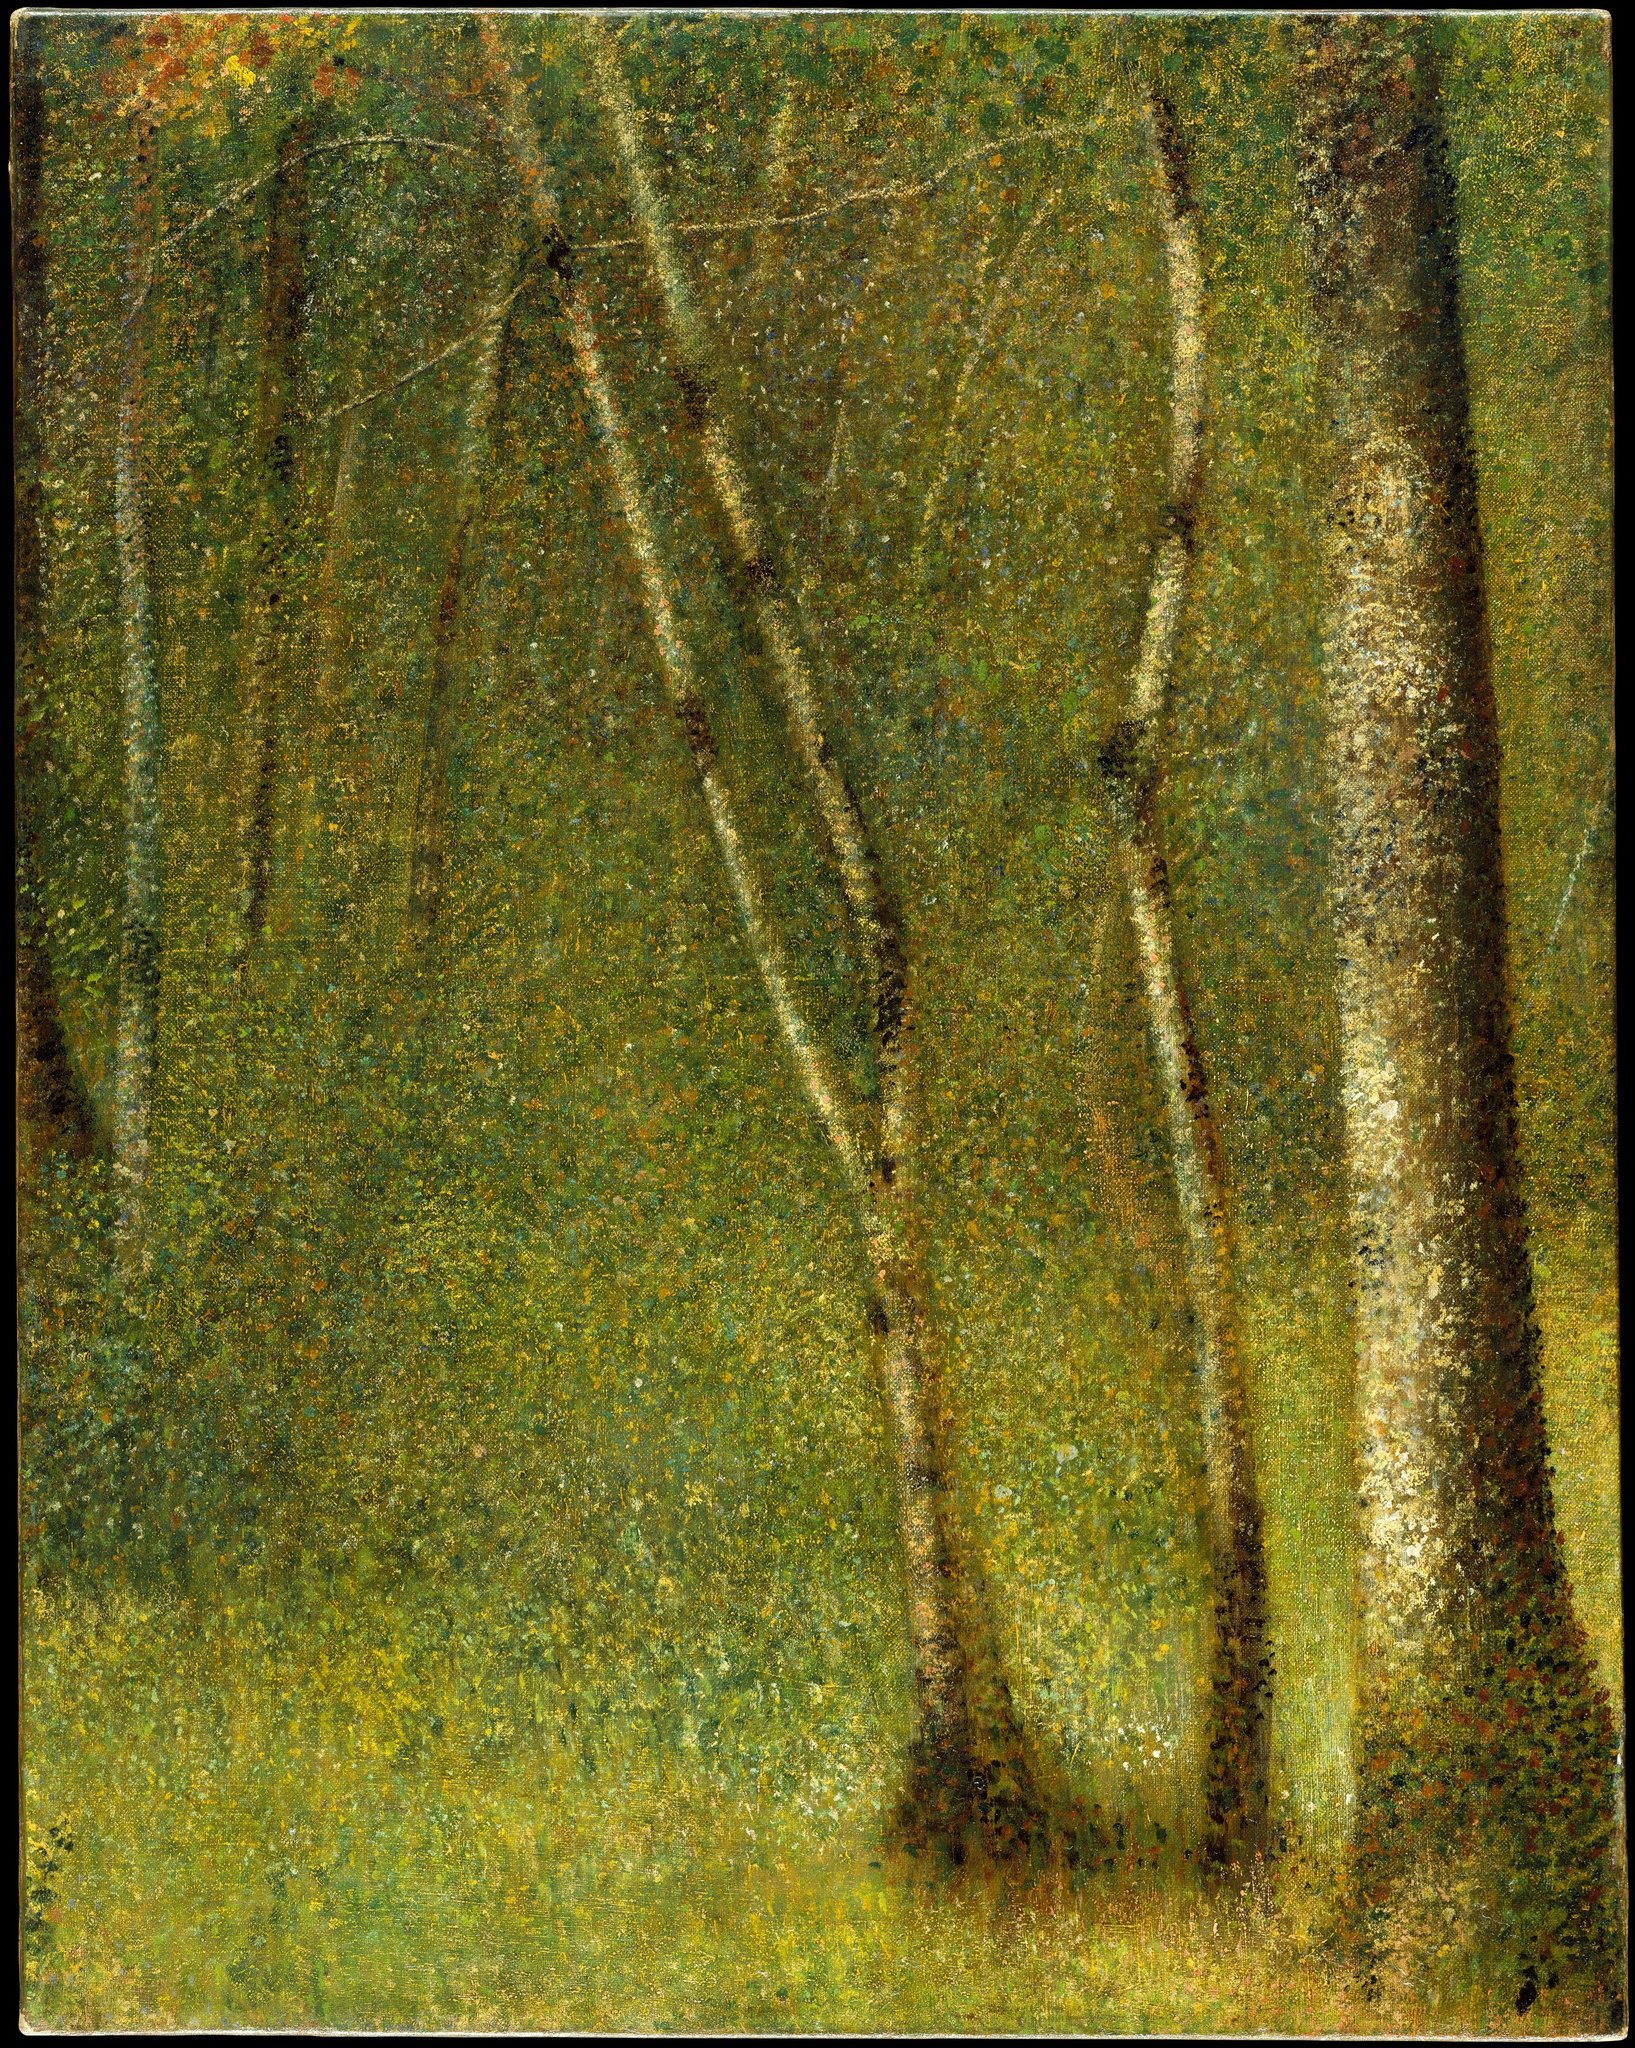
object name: painting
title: The Forest at Pontaubert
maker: georges seurat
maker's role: artist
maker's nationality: french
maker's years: 1859-1891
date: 1881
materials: canvas, oil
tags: forests,trees